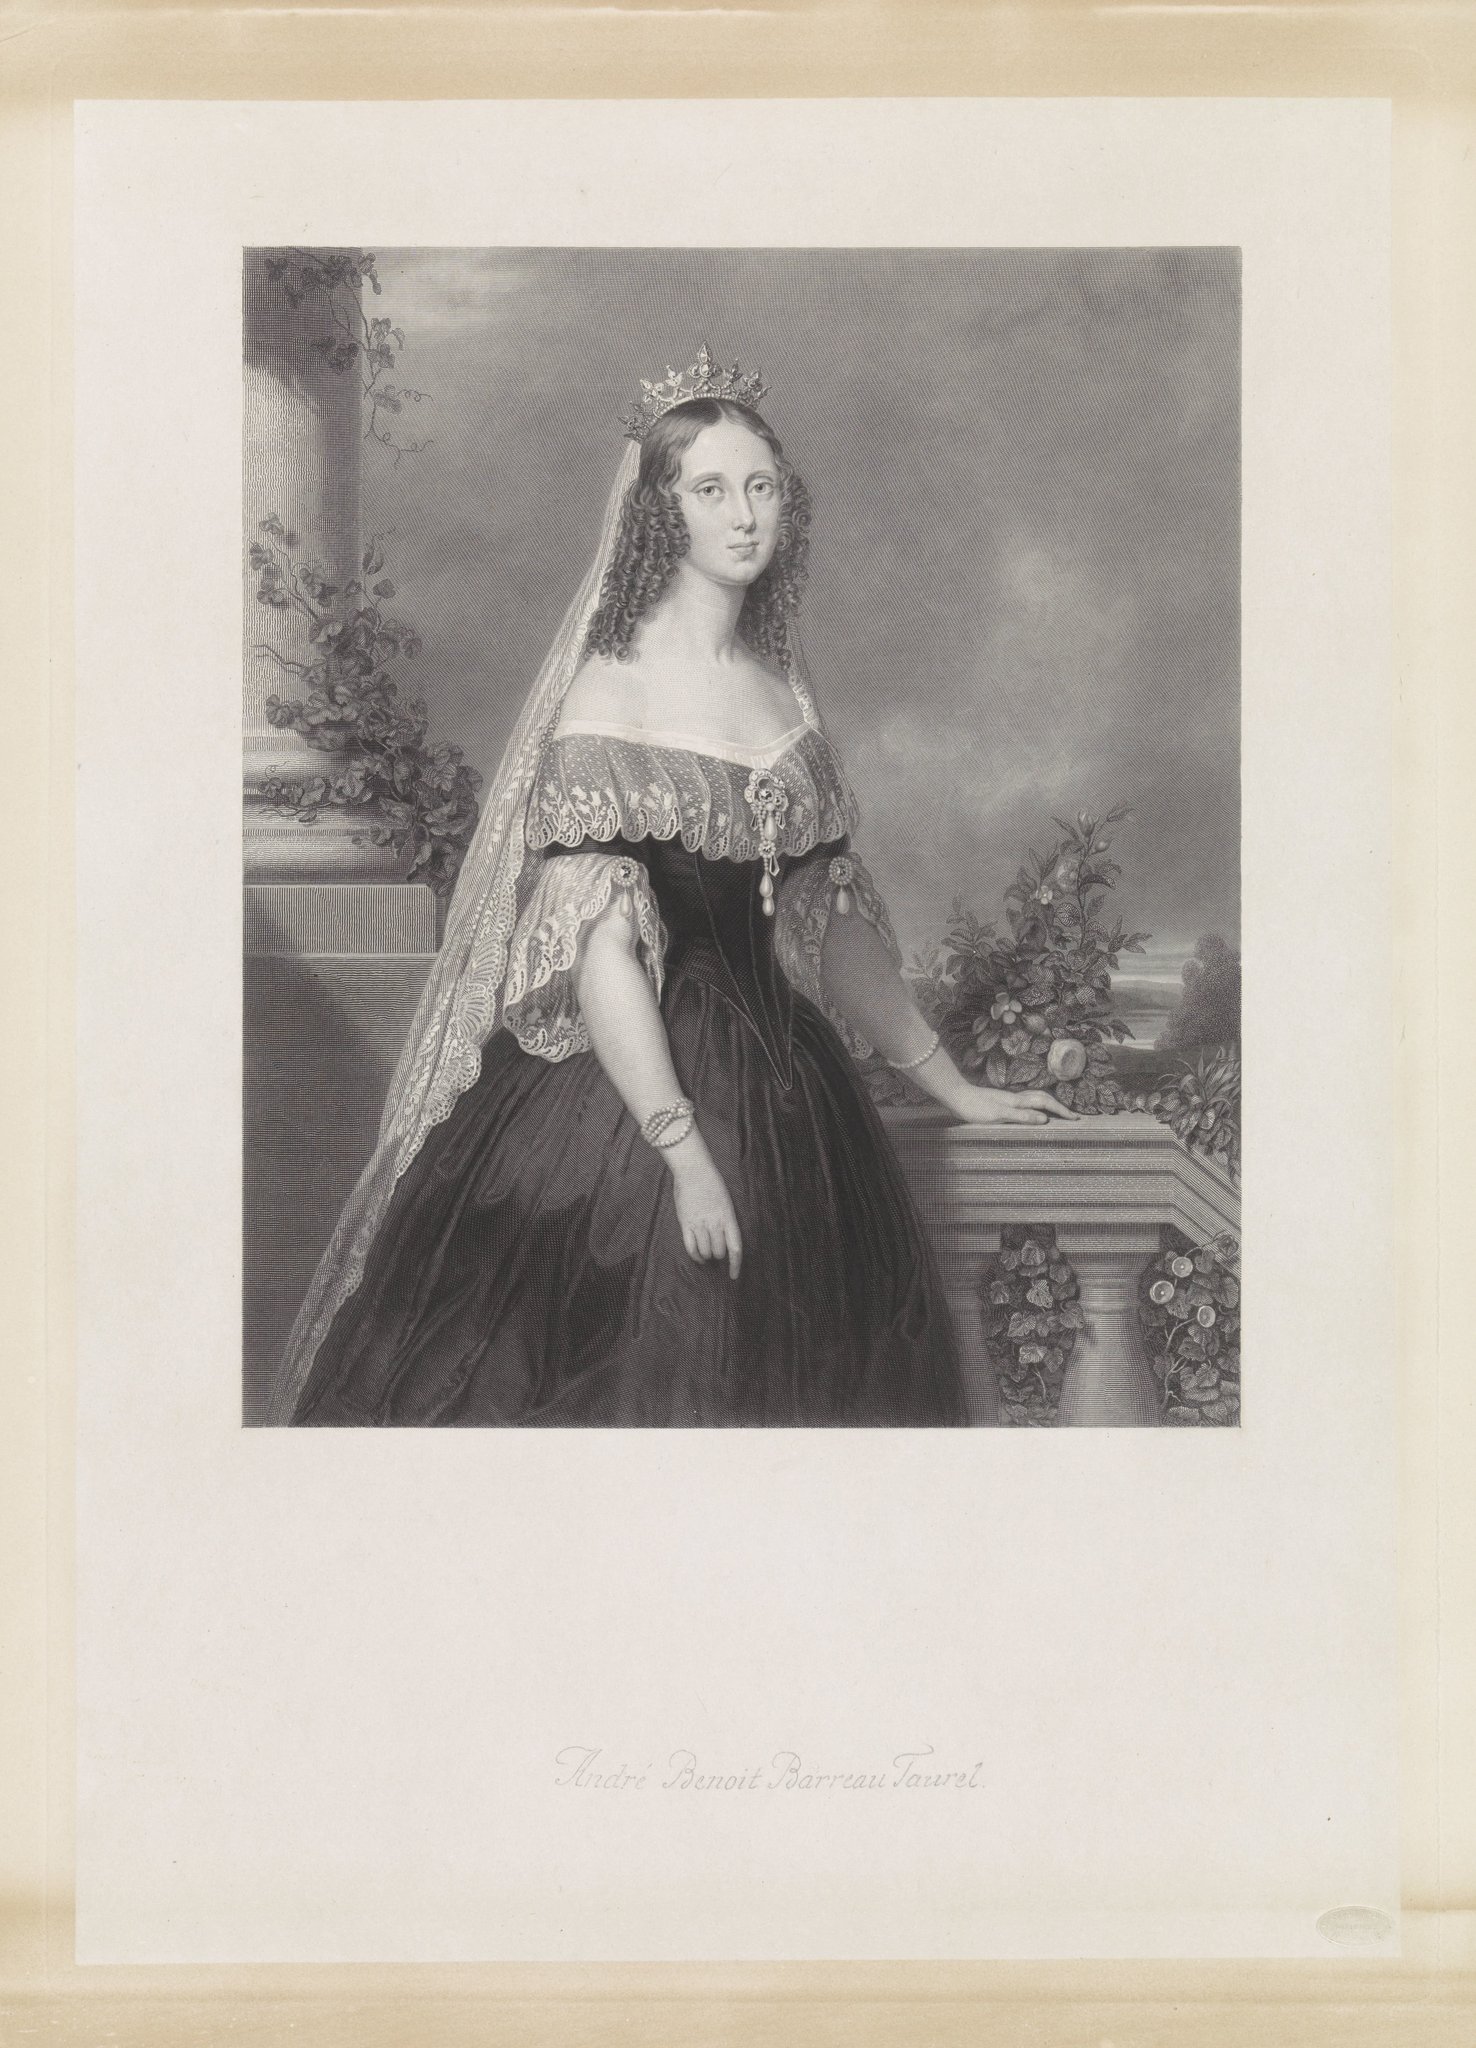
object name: print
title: Portret van Sophia Frederika Mathilda, koningin der Nederlanden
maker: benoit taurel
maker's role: draughtsman, print maker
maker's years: 1794-1859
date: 1849-1877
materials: paper, pencil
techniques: engraving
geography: amsterdam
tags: the hague, sophia frederika mathilda van württemberg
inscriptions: name: ‘André Benoit Barreau Taurel’, collector's mark: Lugt 12, check stamp: ‘Frans Buffa en Zonen uitgevers Amsterdam’